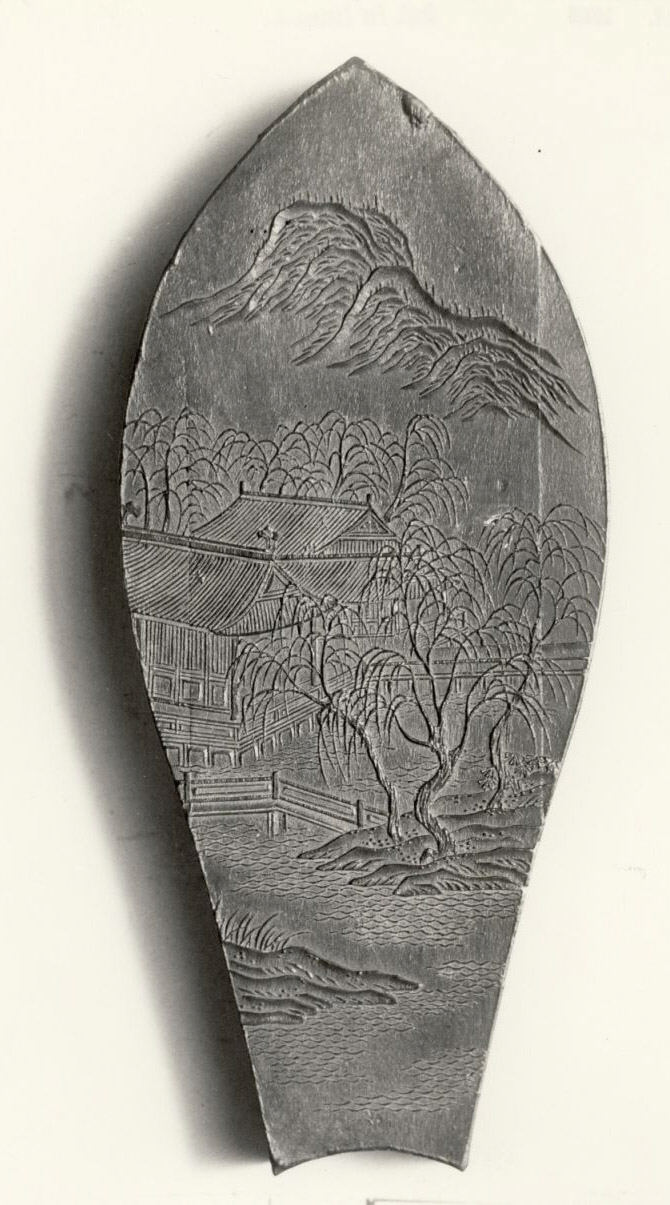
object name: ink tablet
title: The Smoke and Clouds Unfolding and Folding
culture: chinese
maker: jian guzhai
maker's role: artist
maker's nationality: chinese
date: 1867-1933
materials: ink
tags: dragons,pavilions